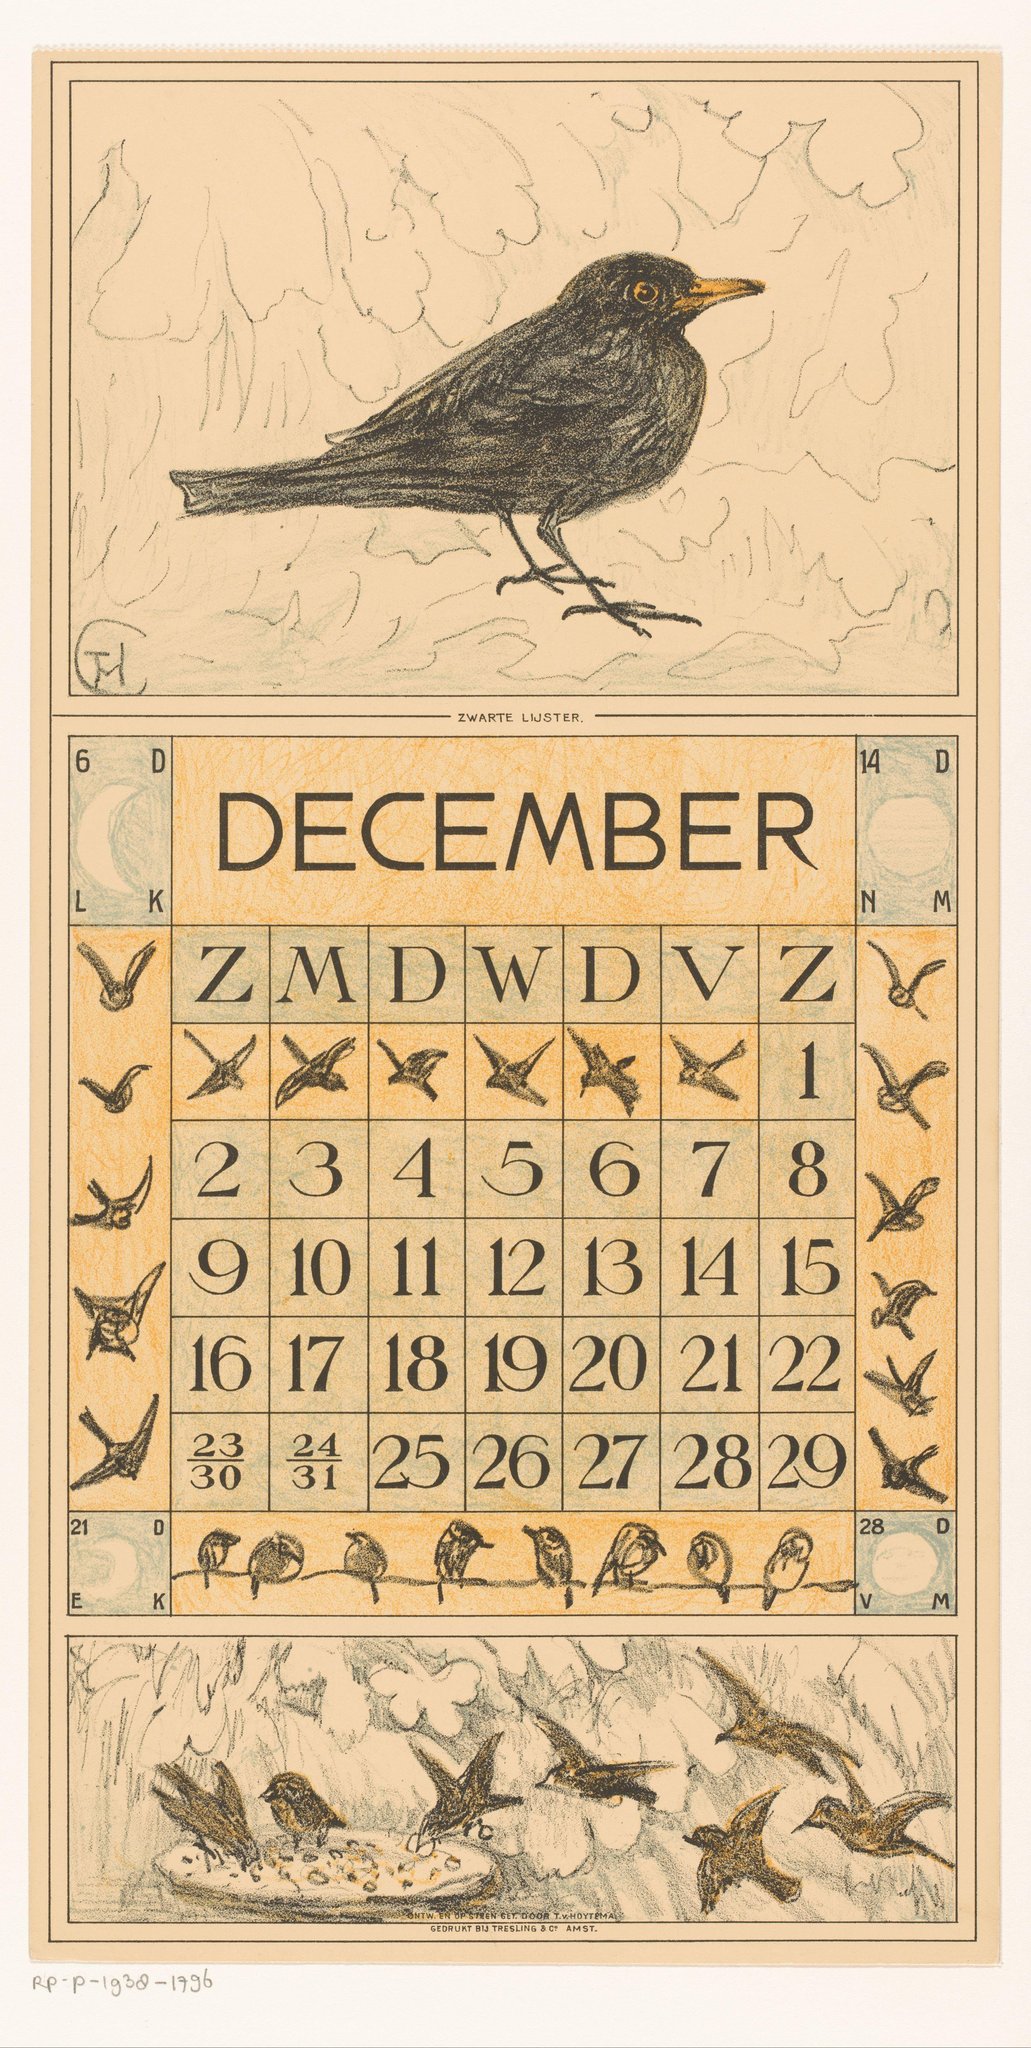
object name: print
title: Kalender 1917 12 lithografien door Th. v. Hoytema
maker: theo van hoytema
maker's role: draughtsman, painter, print maker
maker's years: 1863-1917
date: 1916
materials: paper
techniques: lithograph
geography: amsterdam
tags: song-birds: thrush, birds, birds (+ animals eating and drinking), lunar year, december ~ other concepts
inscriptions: collector's mark: Lugt 2228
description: In de ornamentrand en het calendarium vogels. Onderin een groep vogels bij een voederplaats. In de hoeken de standen van de maan op vier dagen. Bovenaan het blad een scheurlijn.